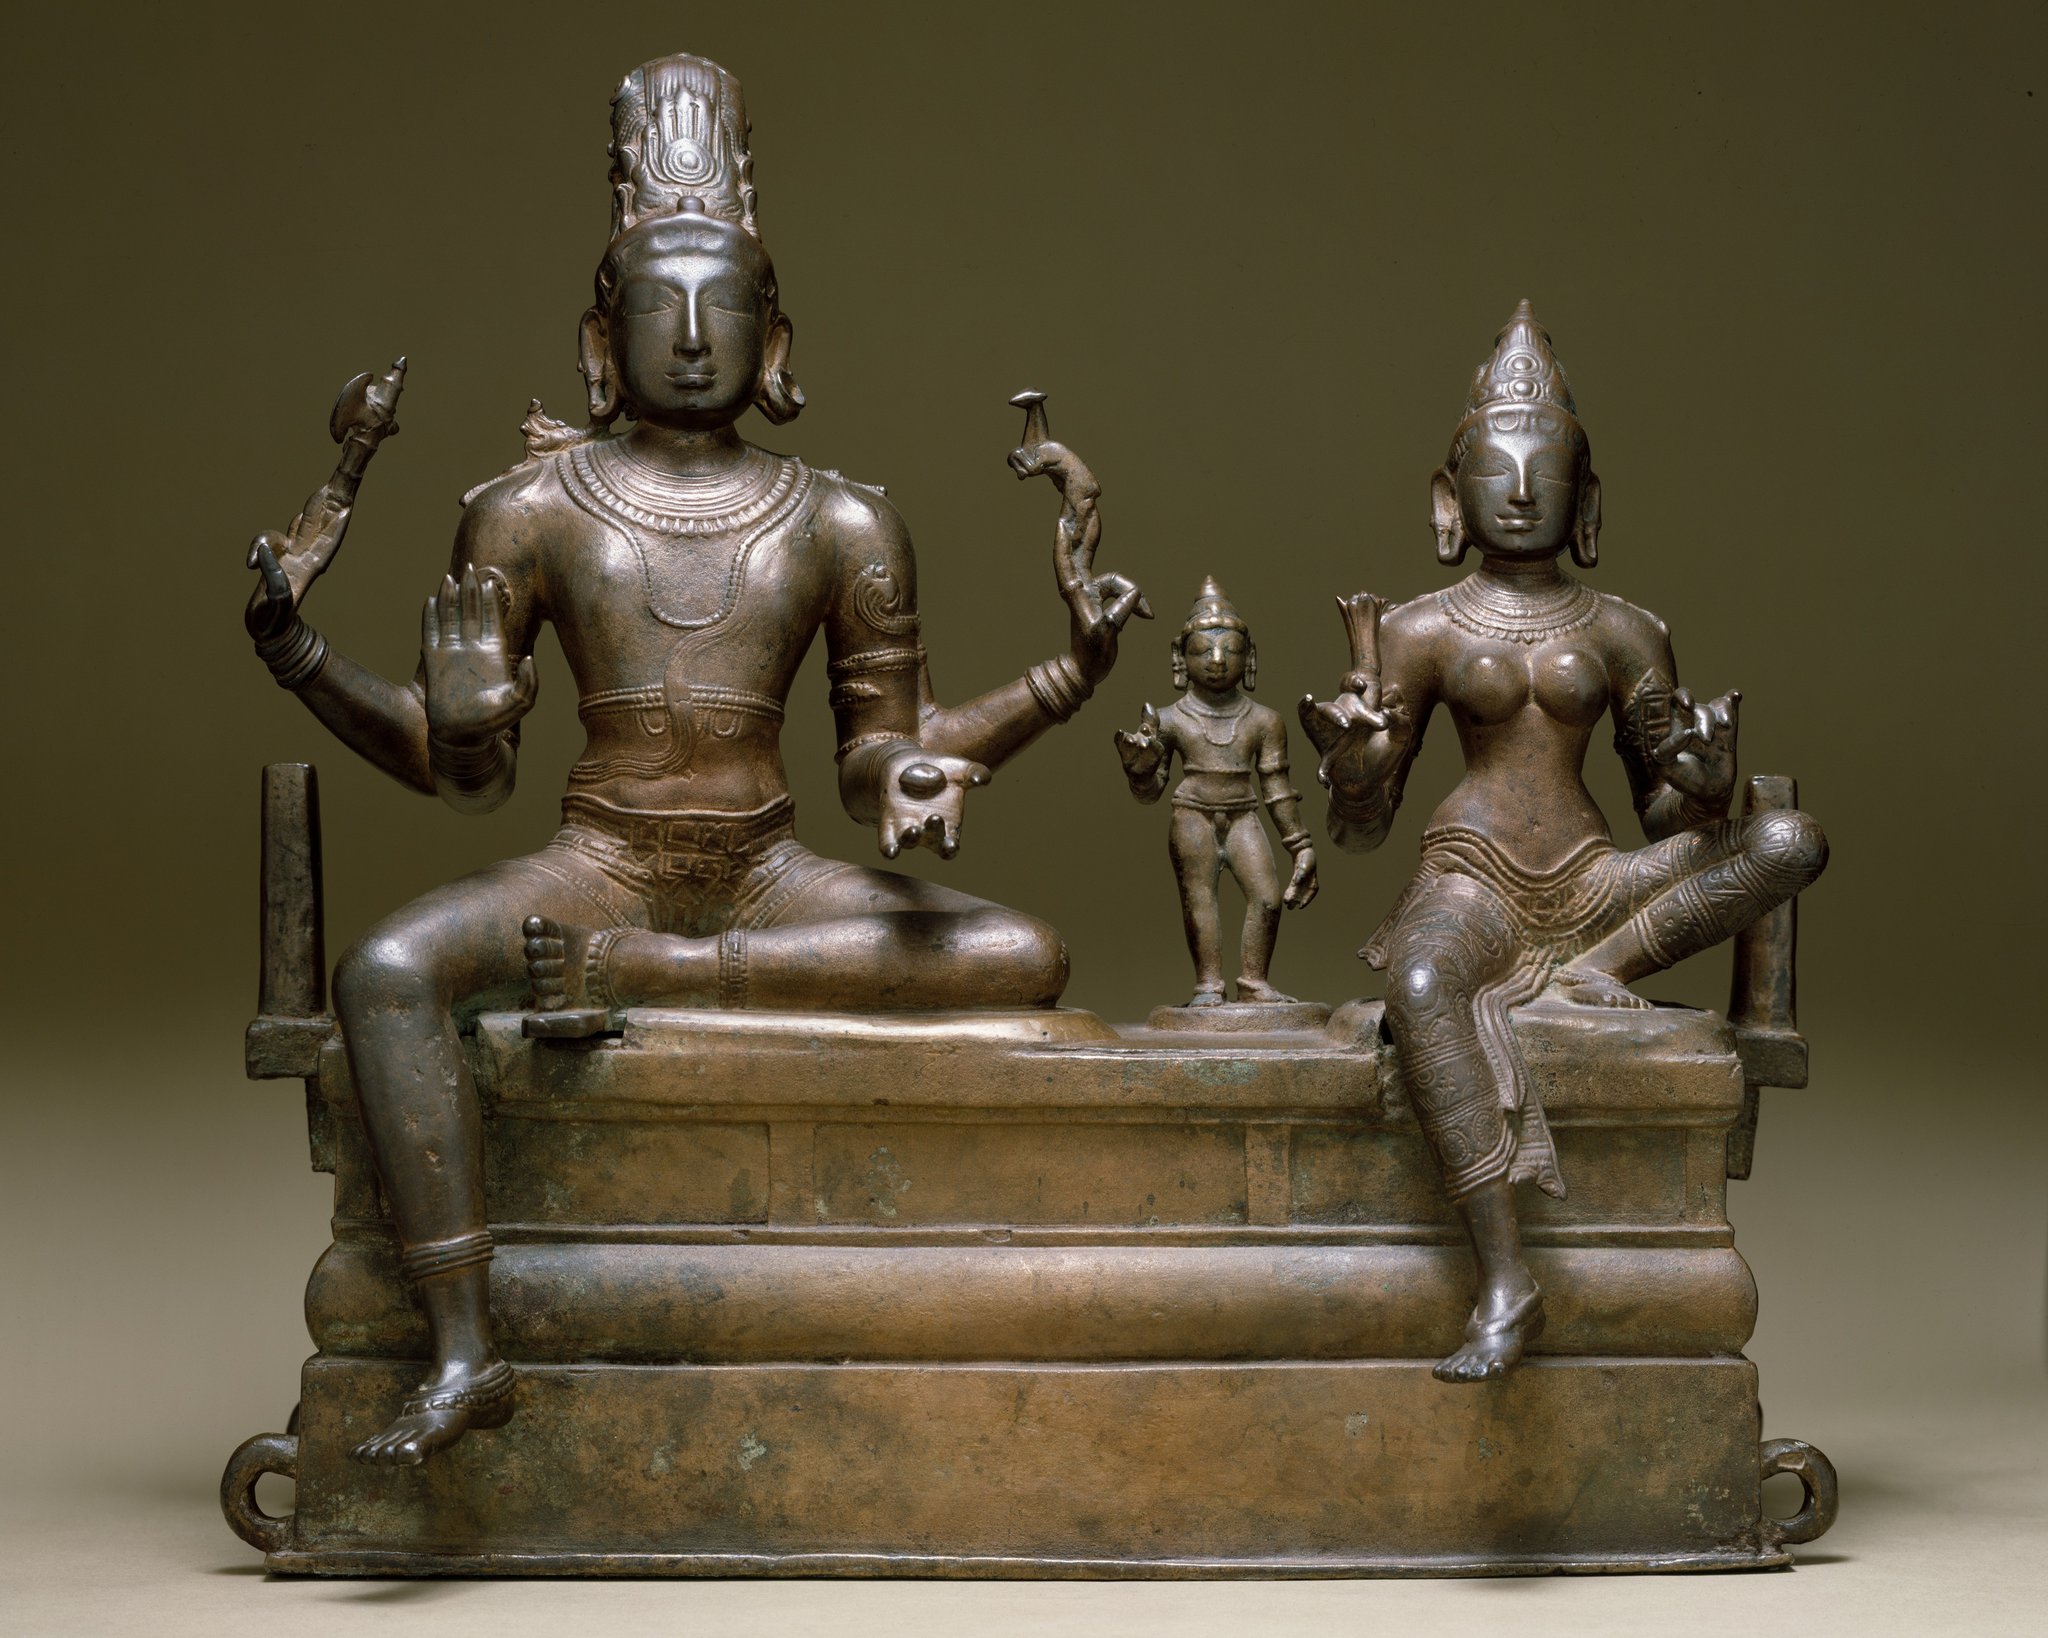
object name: figure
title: Shiva, Uma, and Their Son Skanda (Somaskandamurti)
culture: tamil nadu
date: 1001-1033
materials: copper alloy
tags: goddess,shiva,hinduism